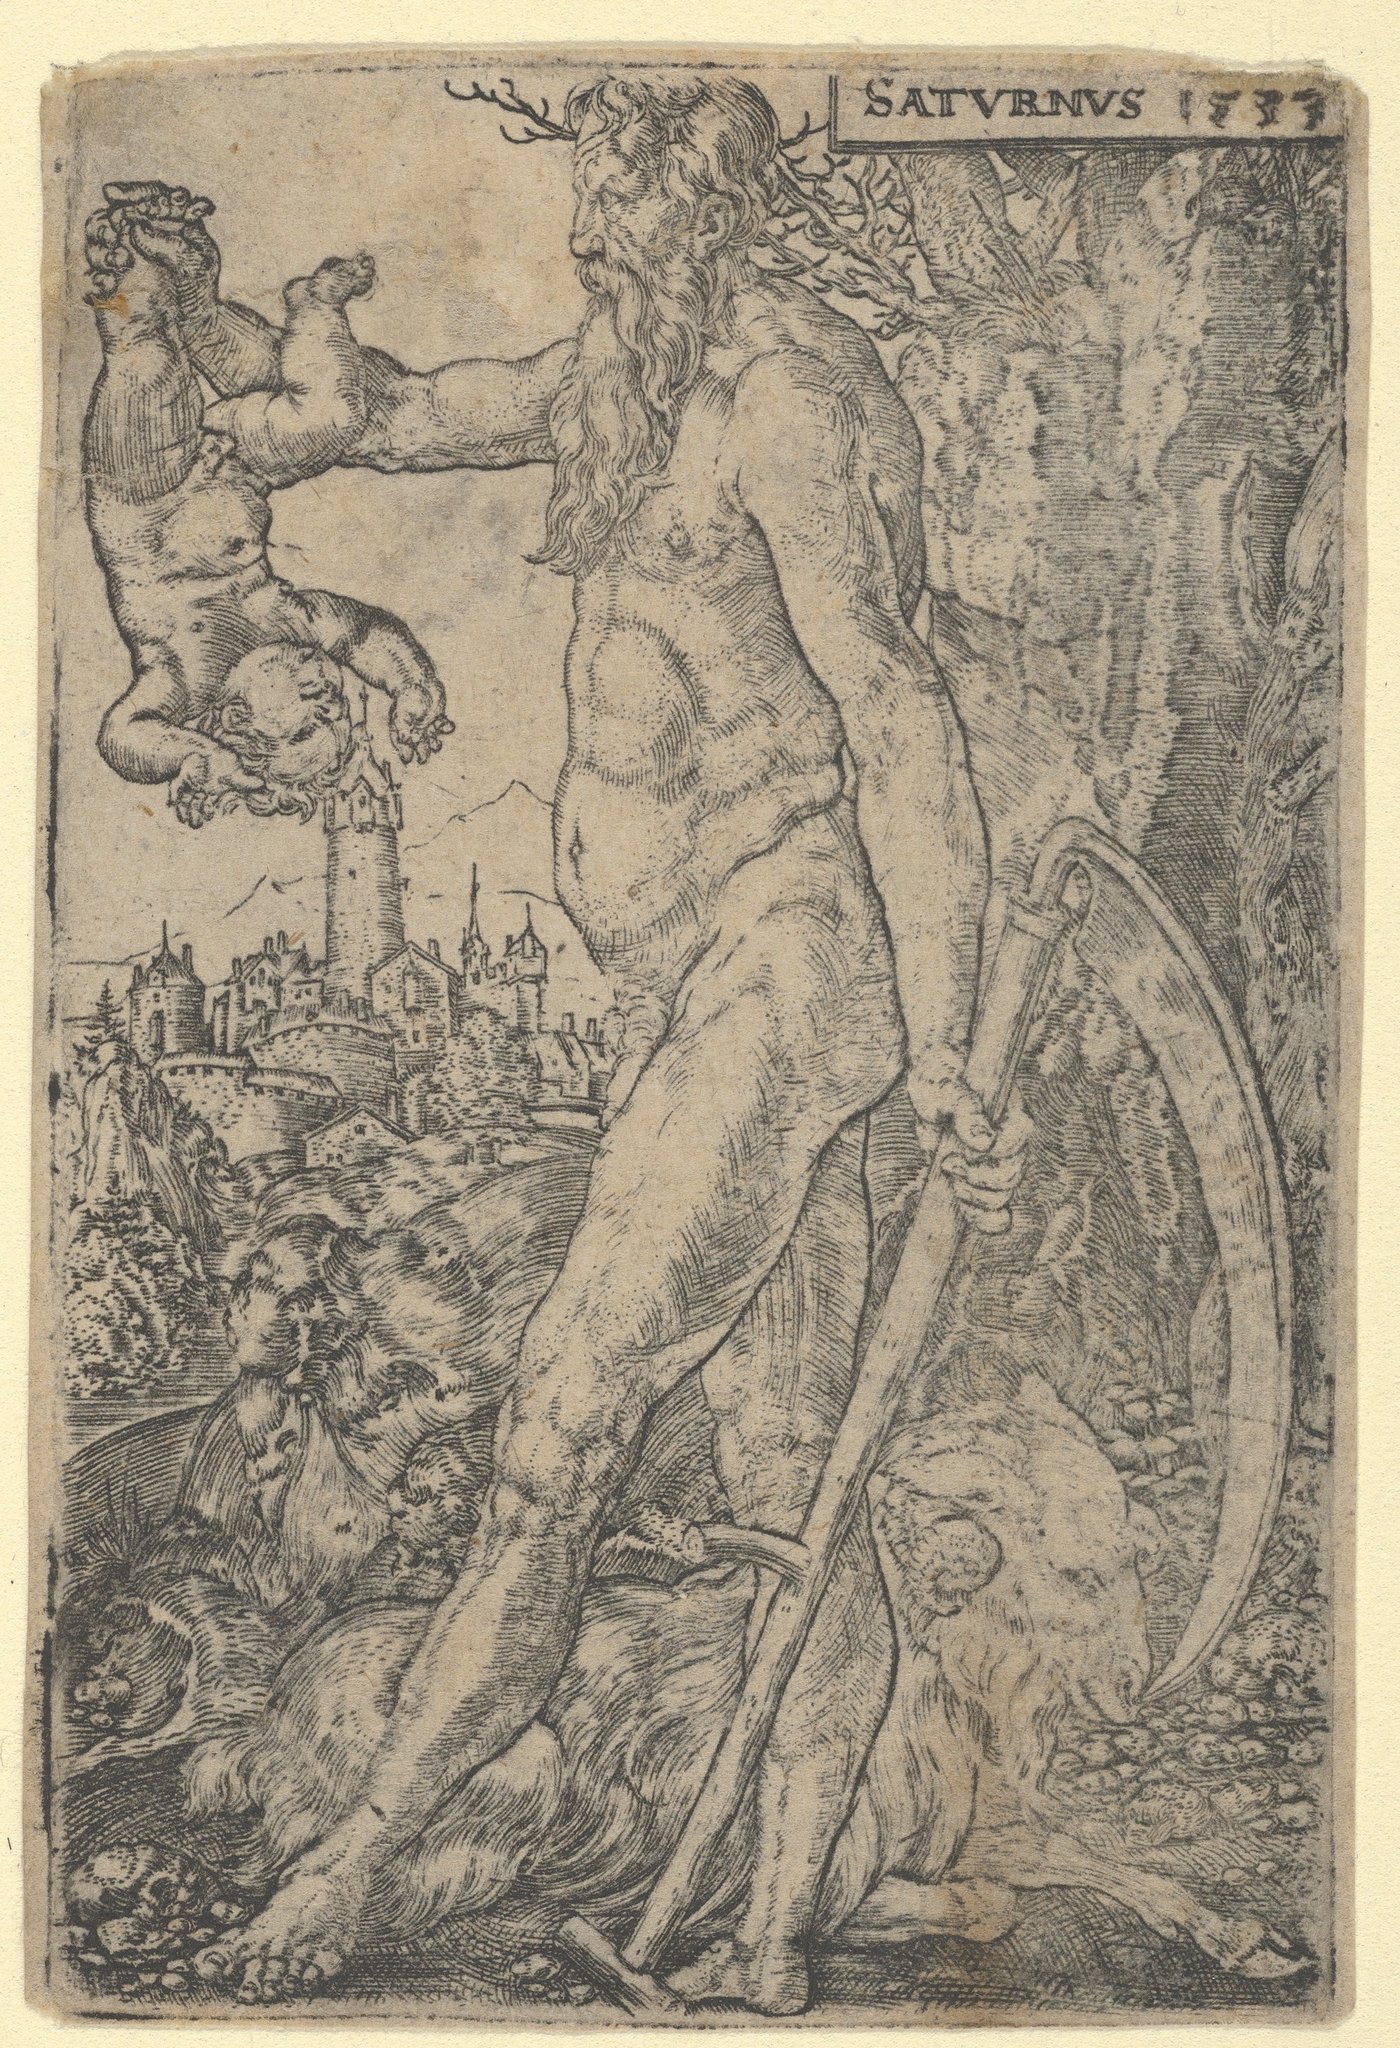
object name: print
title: Saturn, from "The Seven Planets"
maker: heinrich aldegrever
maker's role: artist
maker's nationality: german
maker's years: 1502-1561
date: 1533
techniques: engraving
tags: infants,saturn,rams